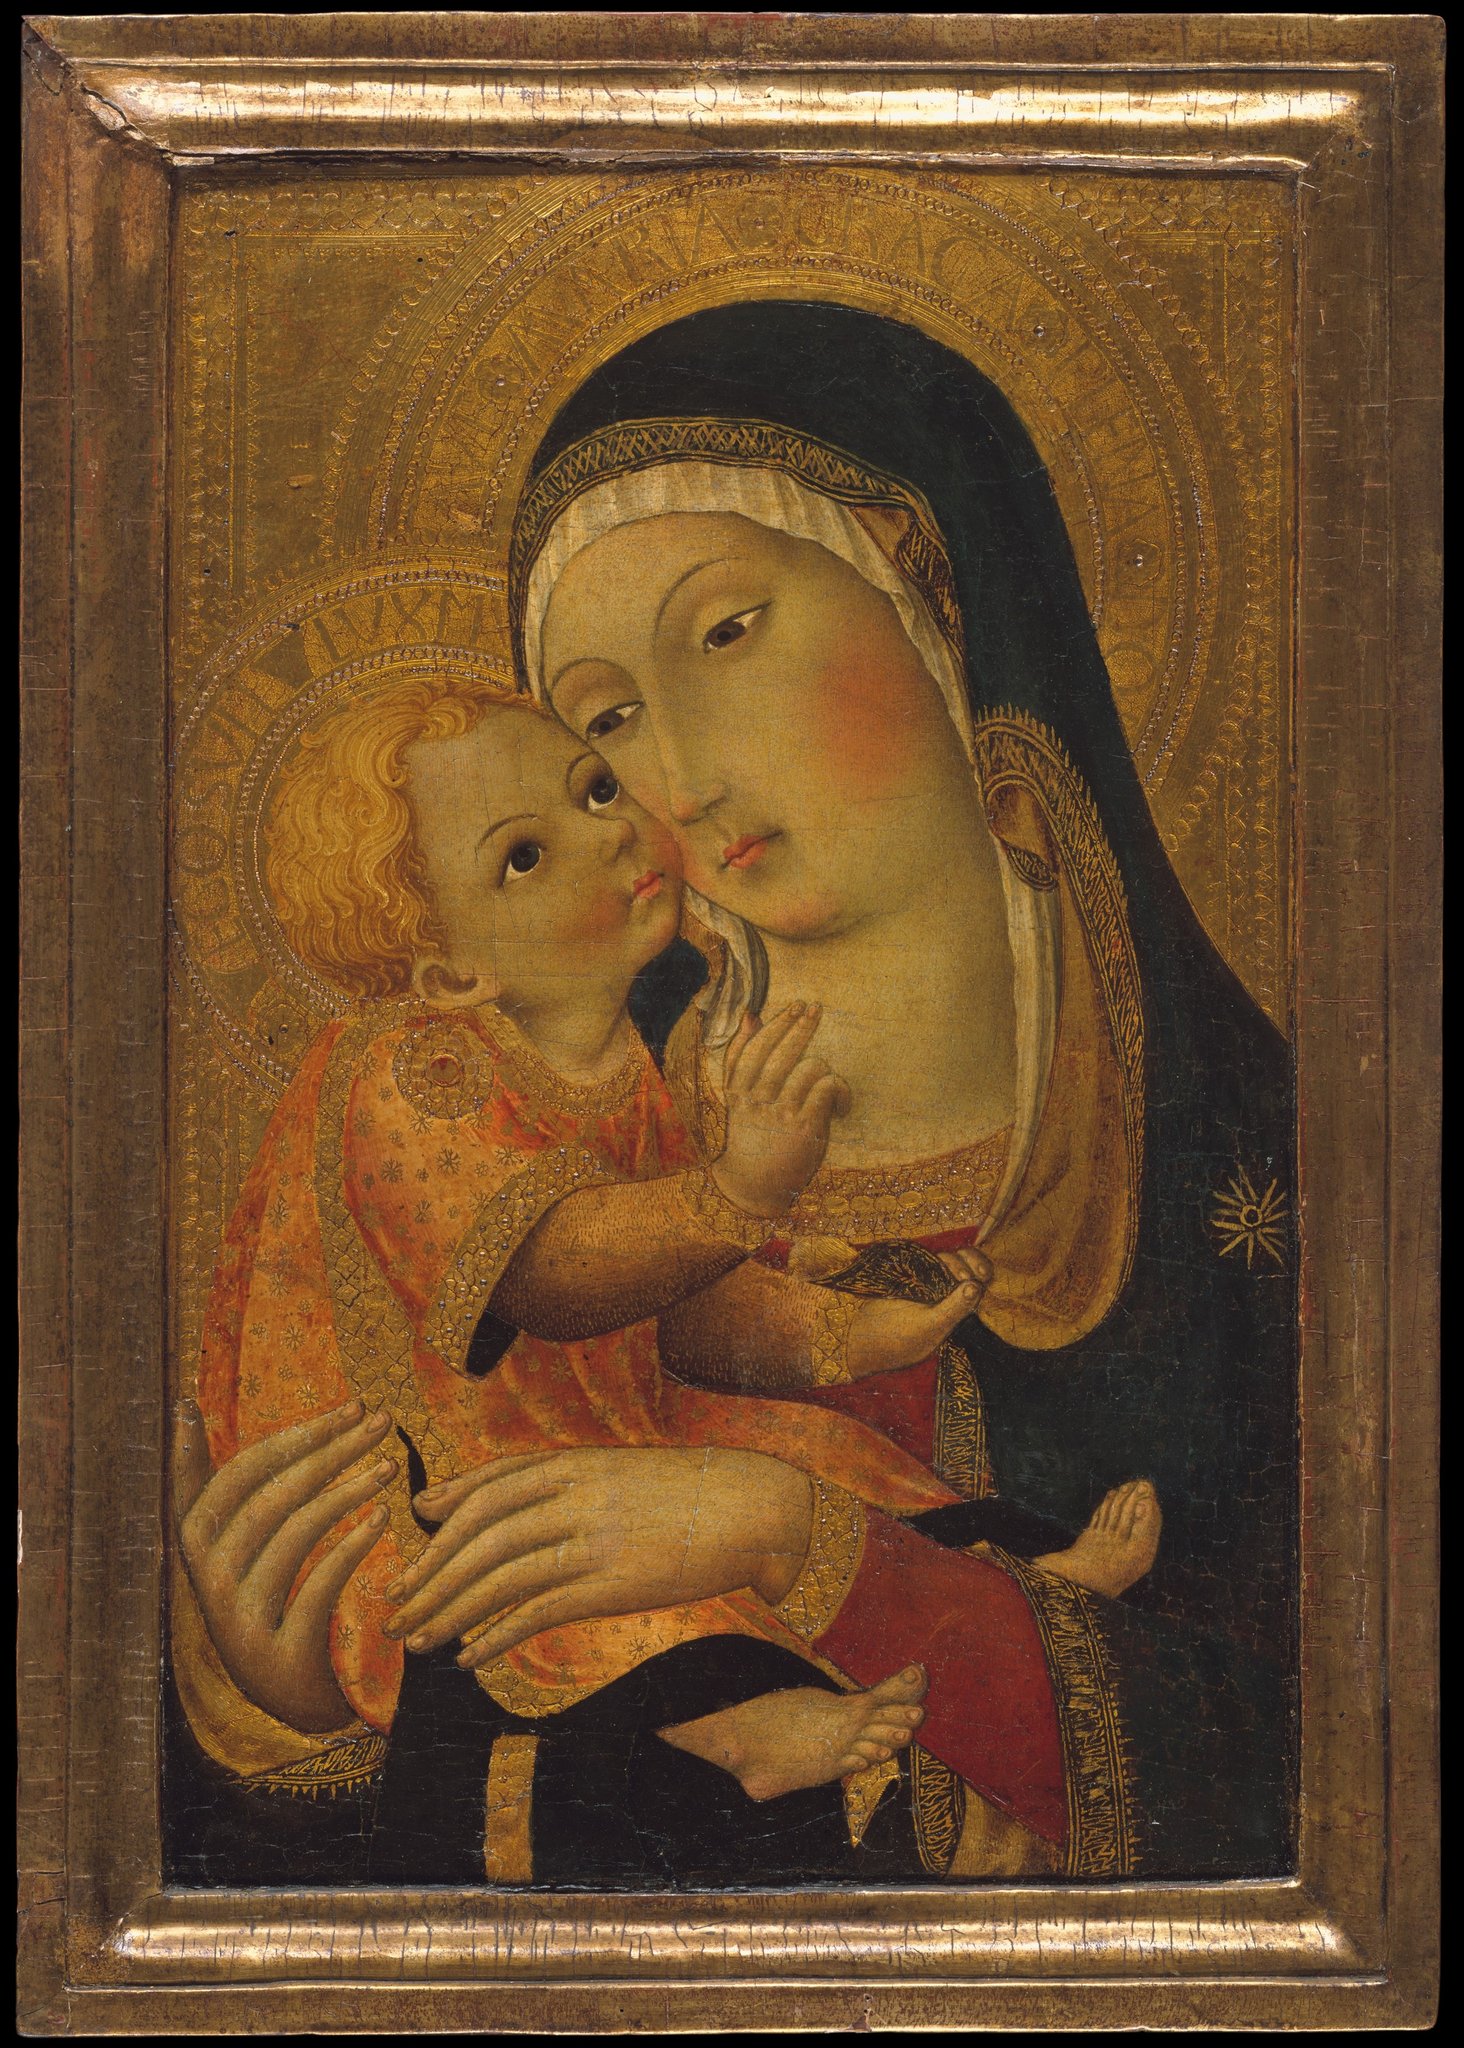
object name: painting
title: Madonna and Child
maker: sano di pietro (ansano di pietro di mencio)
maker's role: artist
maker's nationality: italian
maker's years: 1405-1481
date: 1448-1460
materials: gold leaf, paint, wood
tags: madonna and child